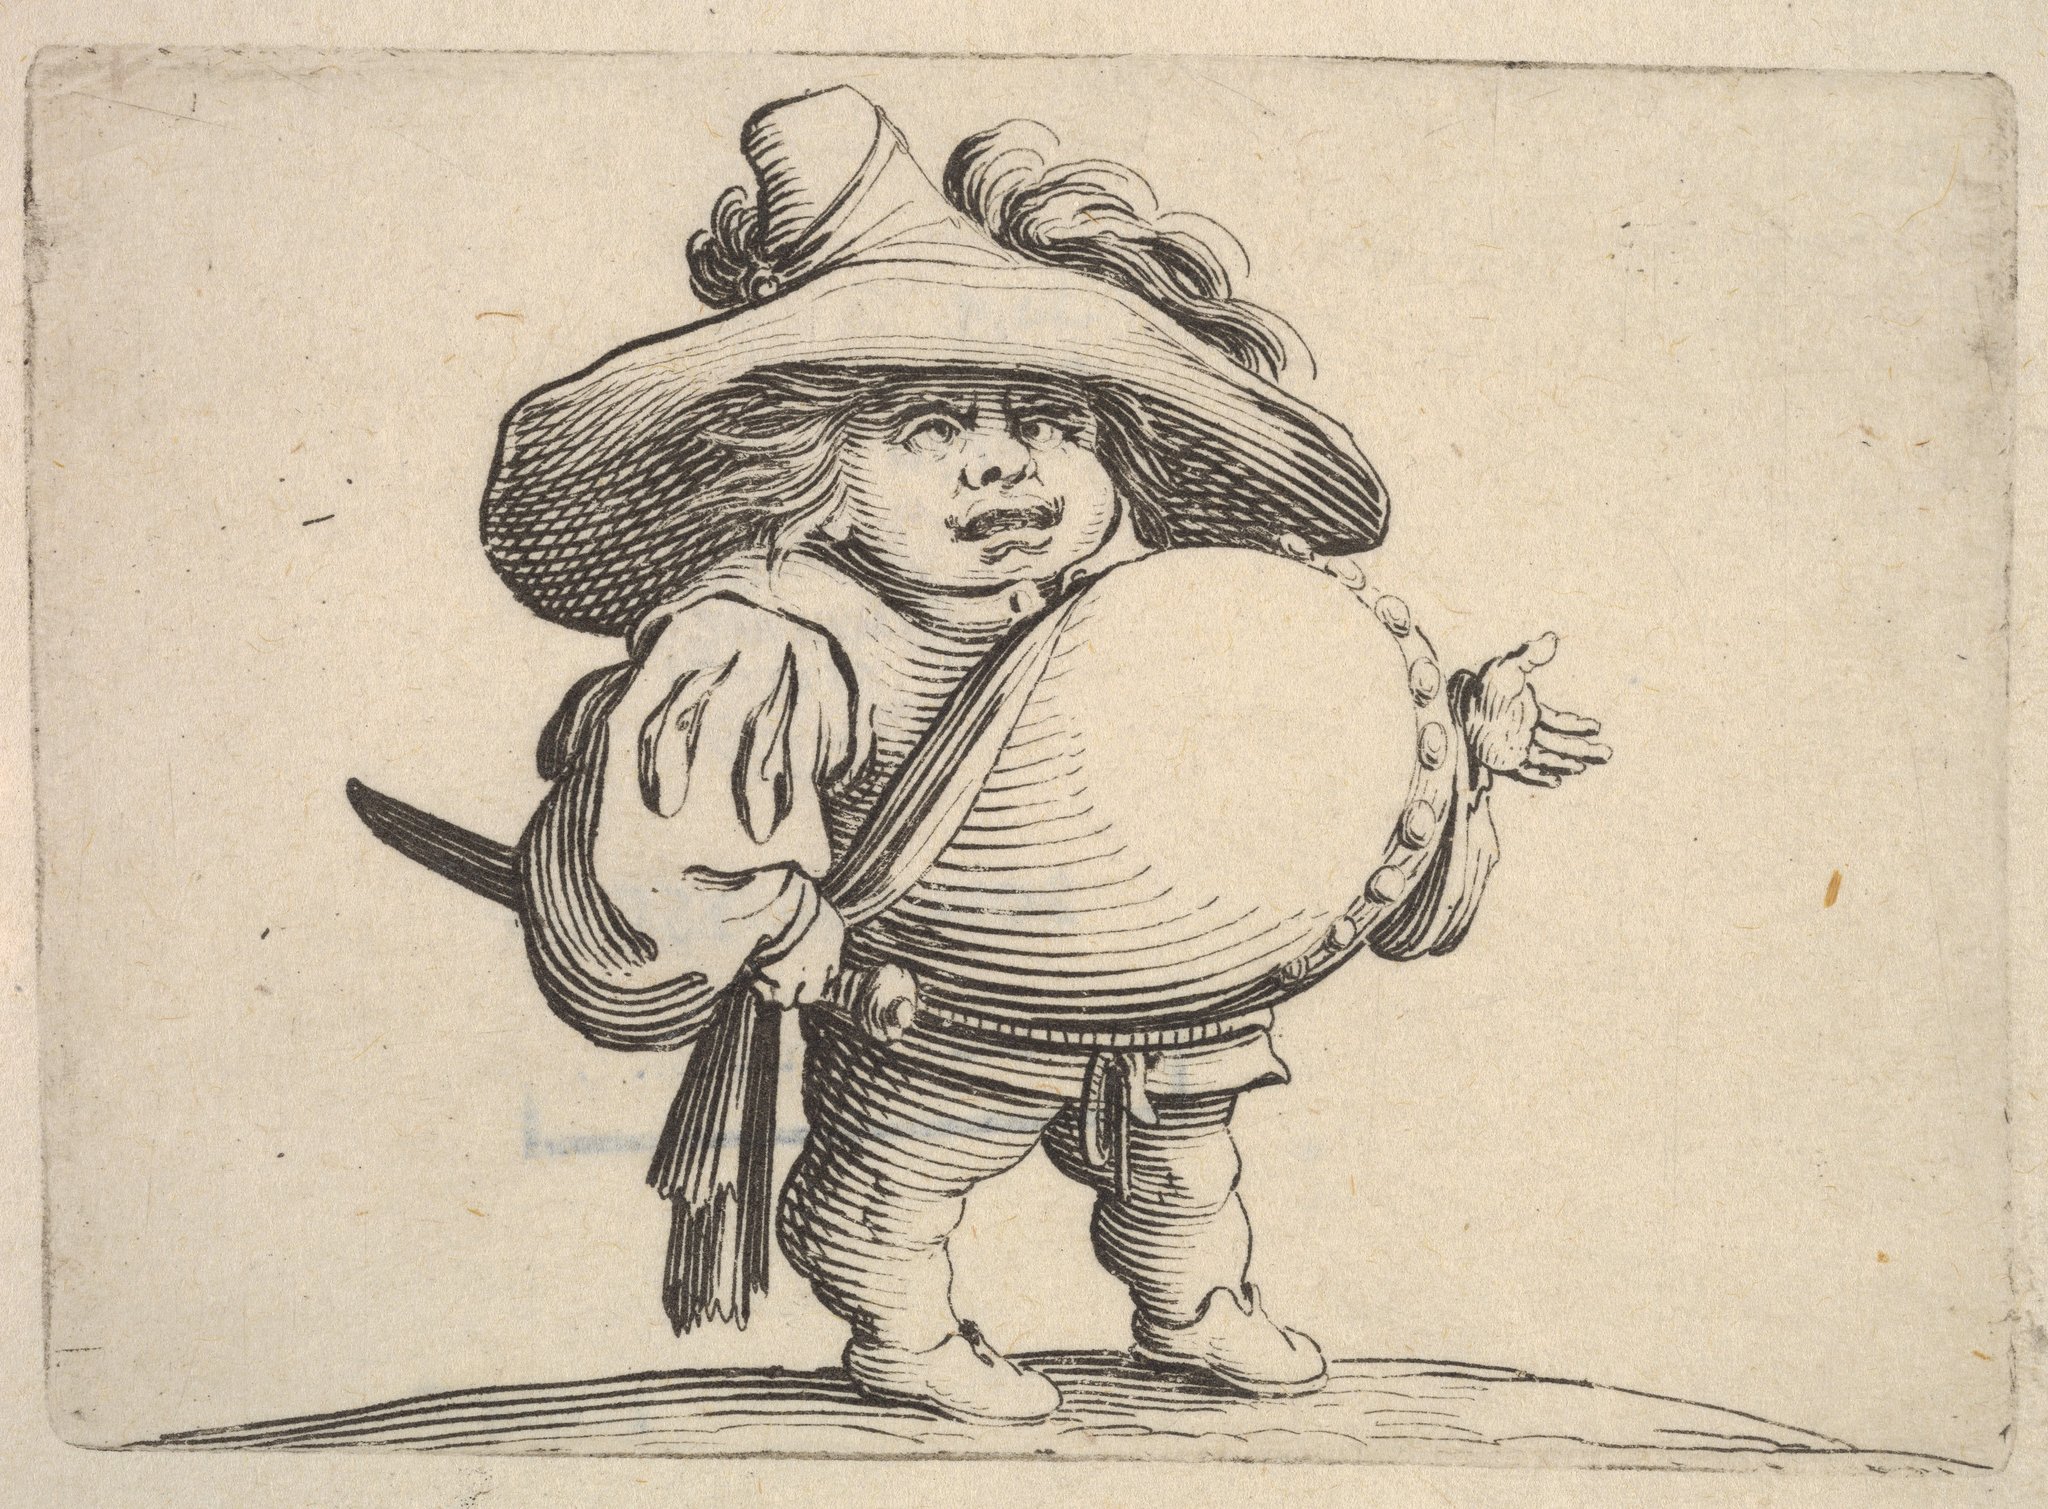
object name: print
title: Small male figure in three-quarter view with outstreched left hand and right hand grasping sword at hip, from "Varie Figure Gobbi"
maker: jacques callot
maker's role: artist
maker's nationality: french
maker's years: 1592-1635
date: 1621-1625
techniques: etching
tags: swords,men